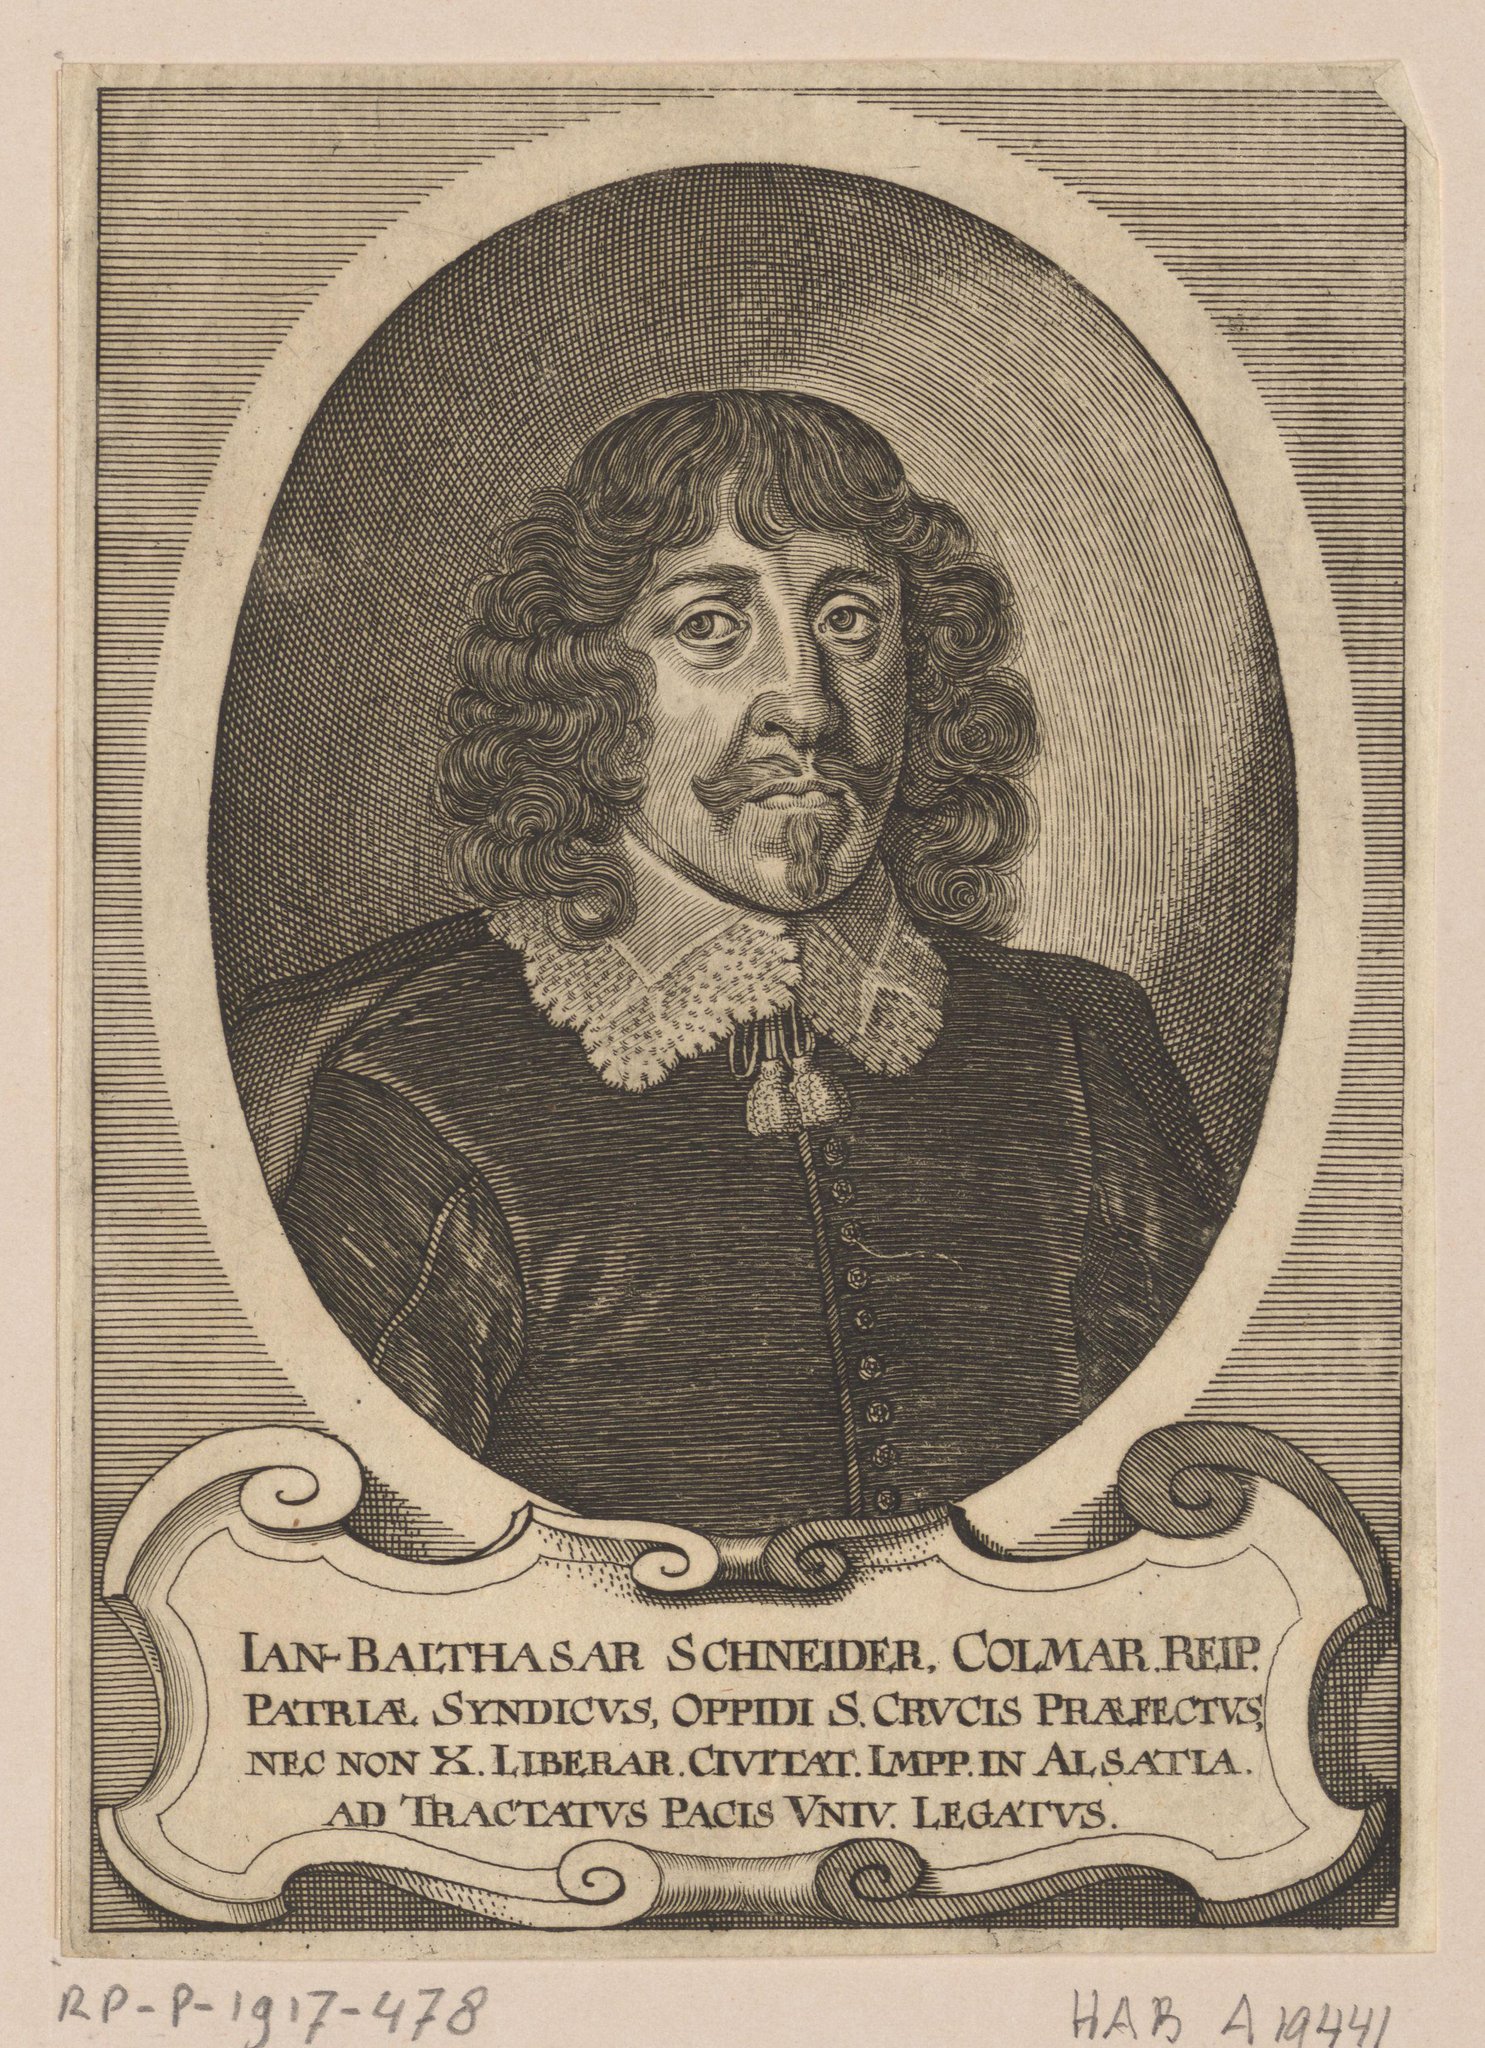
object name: print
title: Portret van Johann Balthasar Schneider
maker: Anonymous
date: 1652-1663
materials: paper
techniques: engraving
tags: historical persons, diplomacy, diplomat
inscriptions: collector's mark: Lugt 2228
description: Prent mogelijk uit: Theatrum Europaeum (...). 1e druk. Frankfurt: erven Matthaus Merian, 1652, dl. 6. De prent is ook gebruikt in de tweede druk uit 1663.